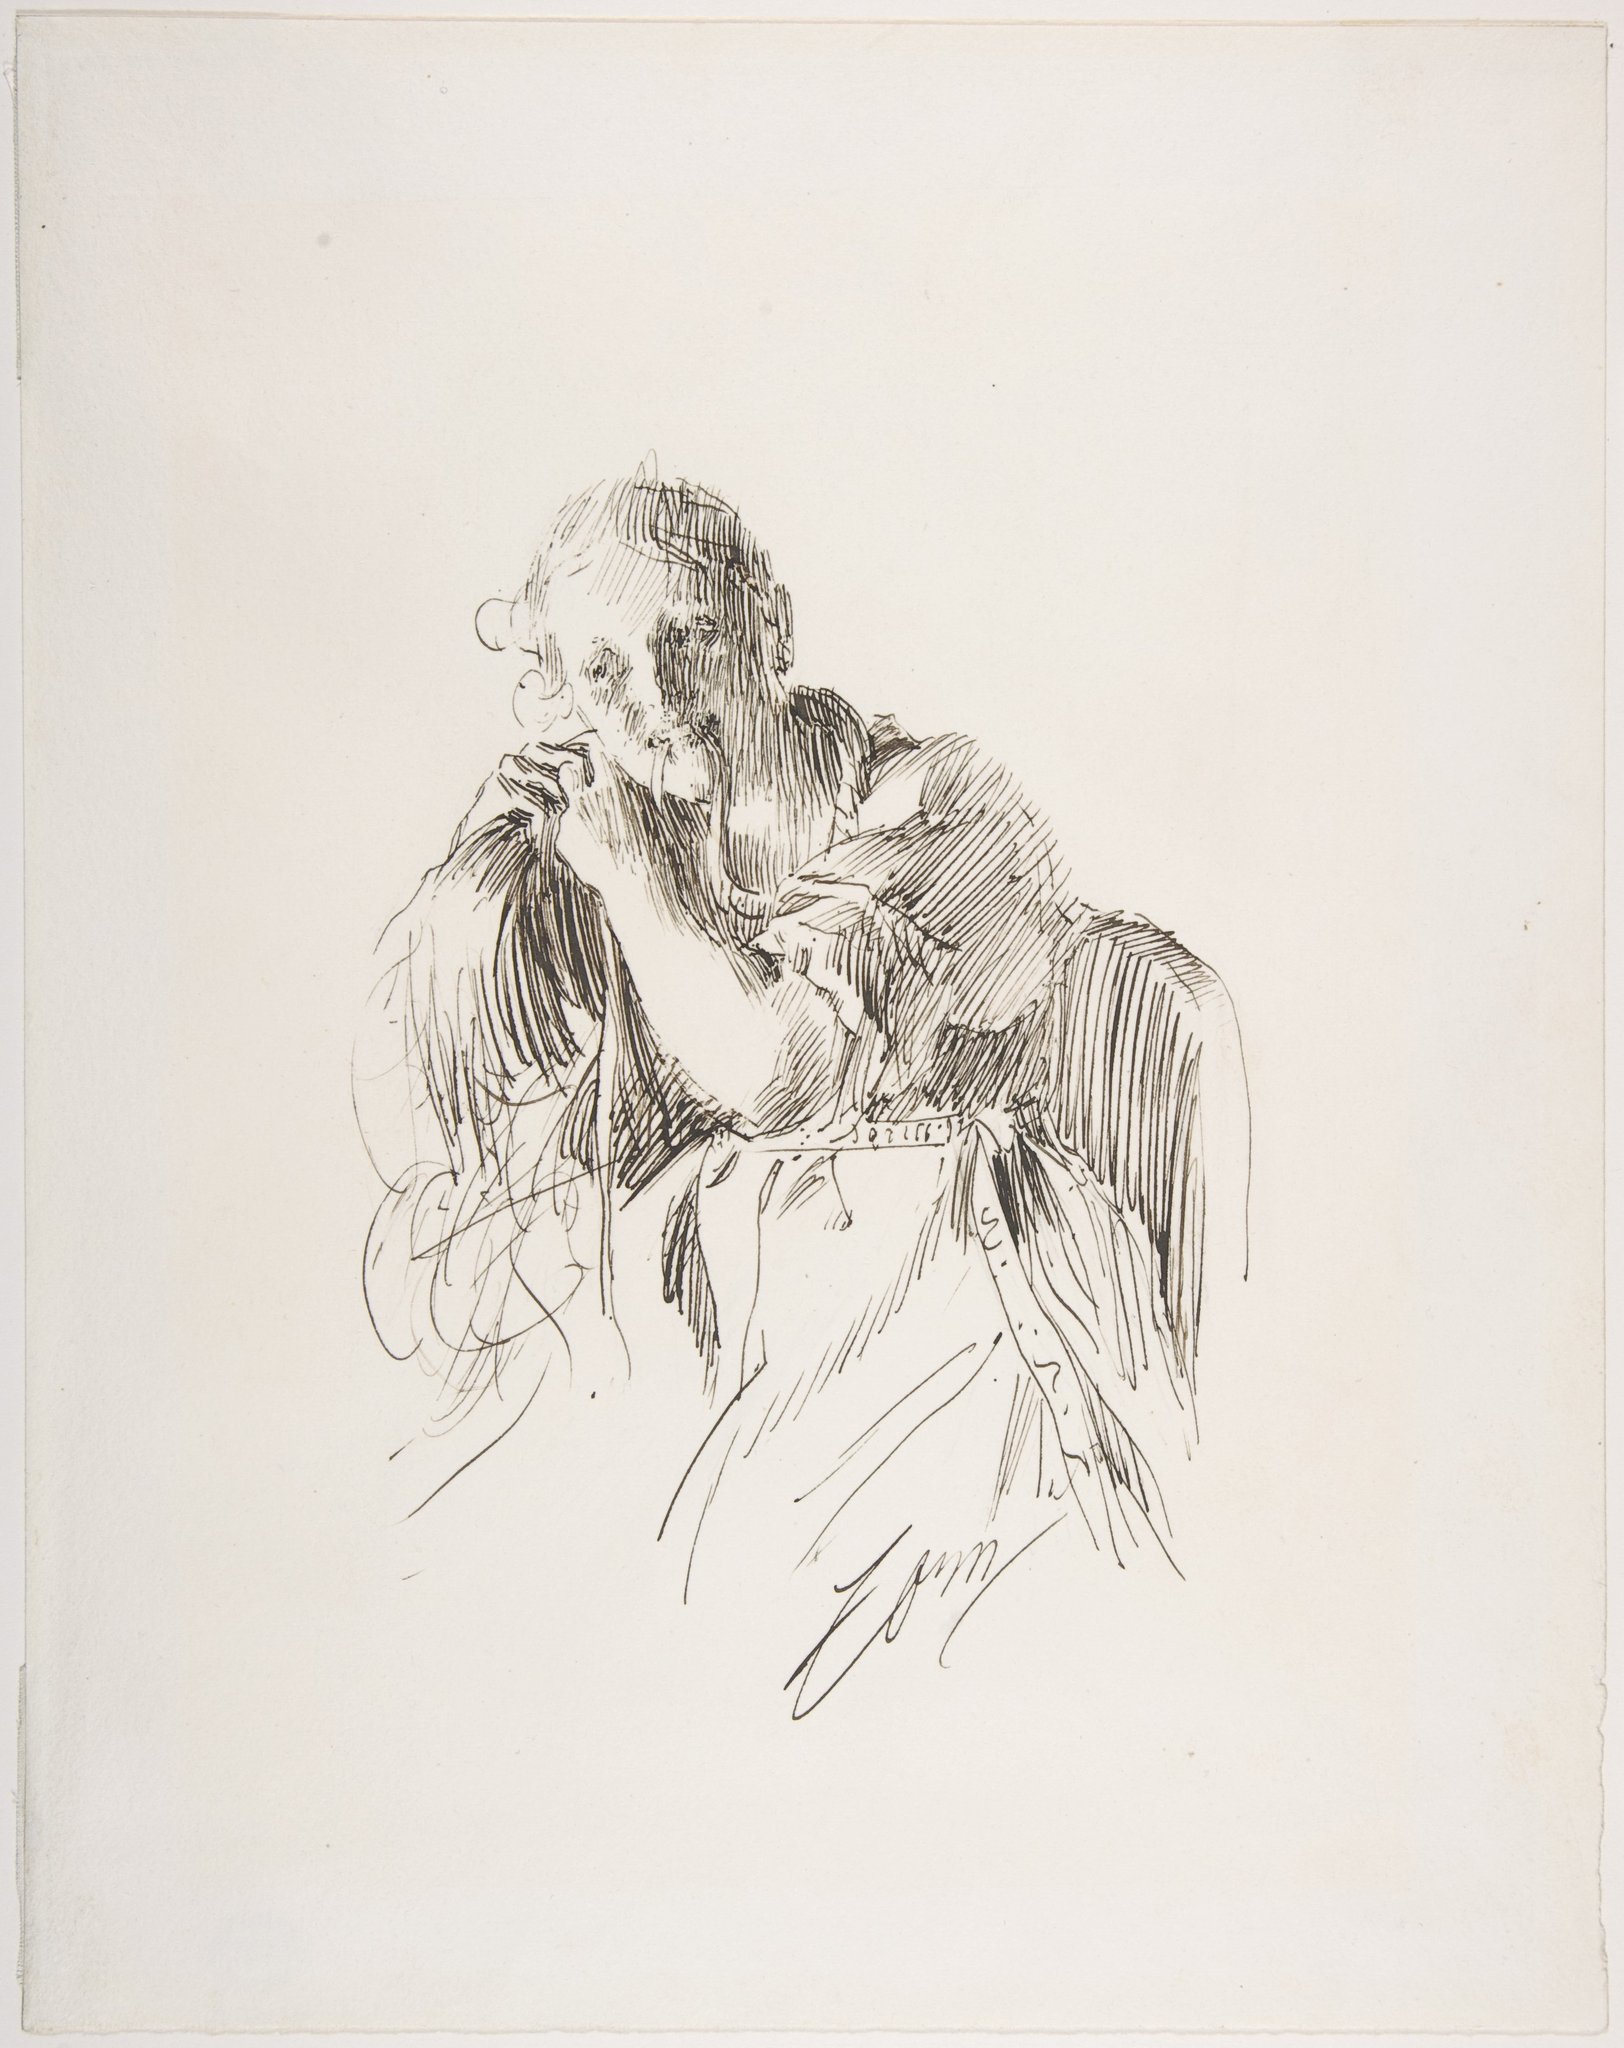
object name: drawing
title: Margit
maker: anders zorn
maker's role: artist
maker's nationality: swedish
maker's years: 1860-1920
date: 1867-1933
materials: ink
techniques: pen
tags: women